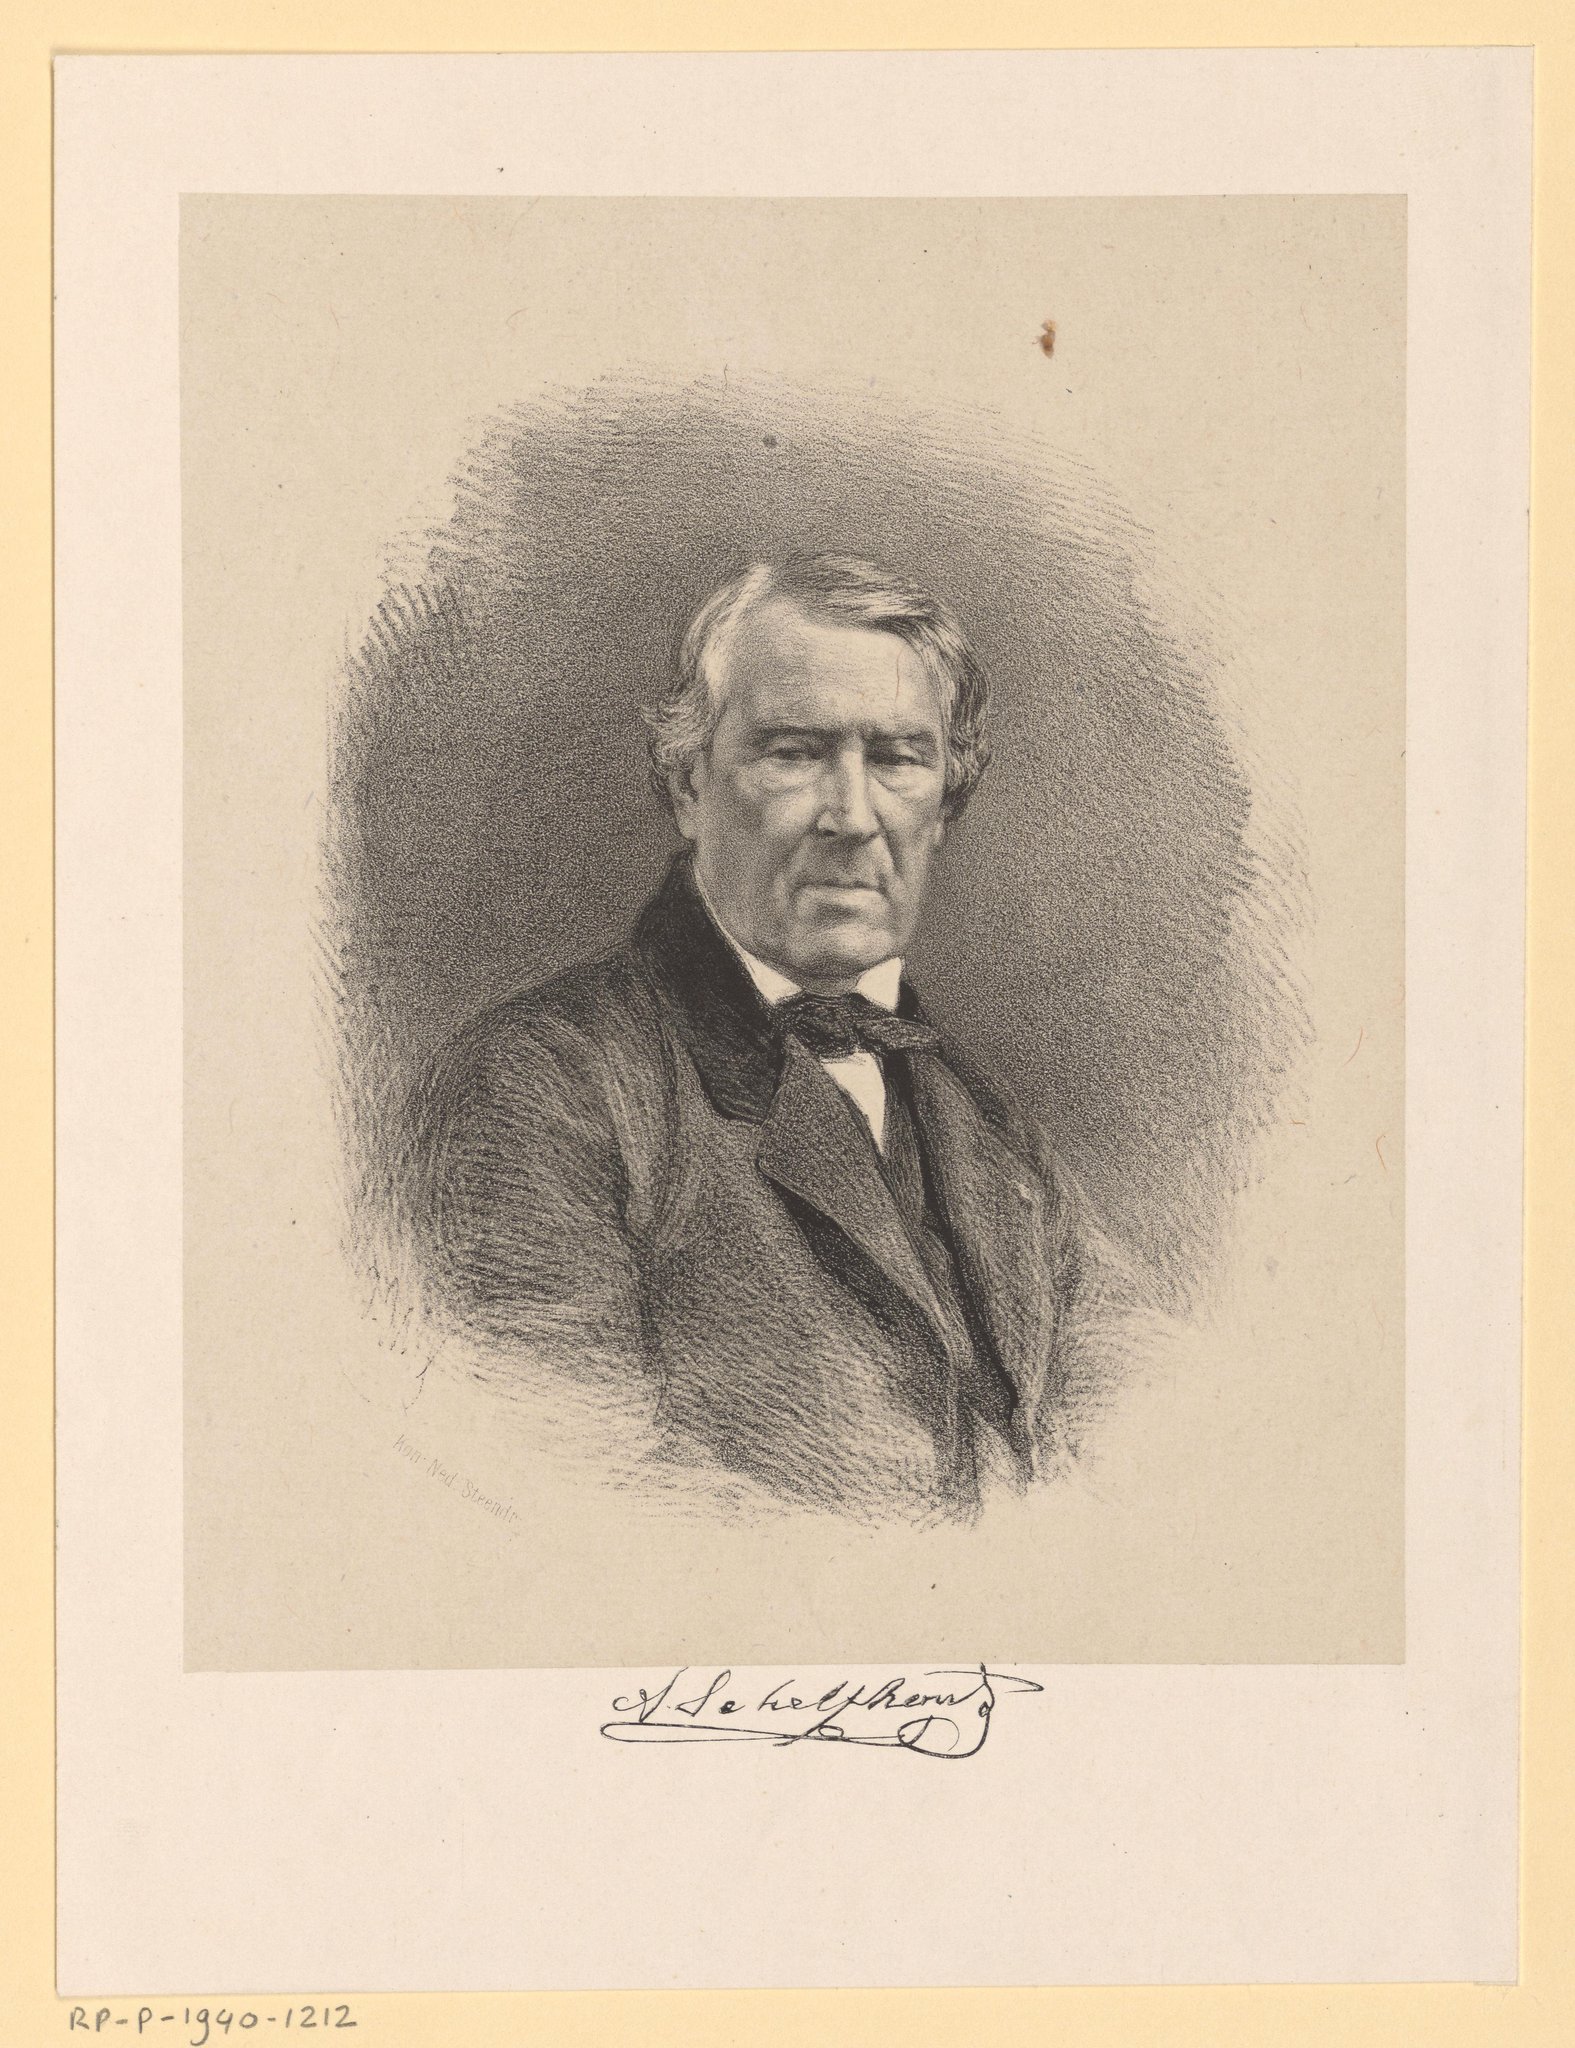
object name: print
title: Portret van Andreas Schelfhout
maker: jan mesker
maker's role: print maker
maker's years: 1843-1890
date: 1871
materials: paper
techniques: lithograph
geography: the hague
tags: the hague, painter, andreas schelfhout, historical persons, portrait, self-portrait of painter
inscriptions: collector's mark: Lugt 2228, collector's mark: Lugt 2760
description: Prent waarschijnlijk uit: Kunstkronijk (...) 12 (1871).